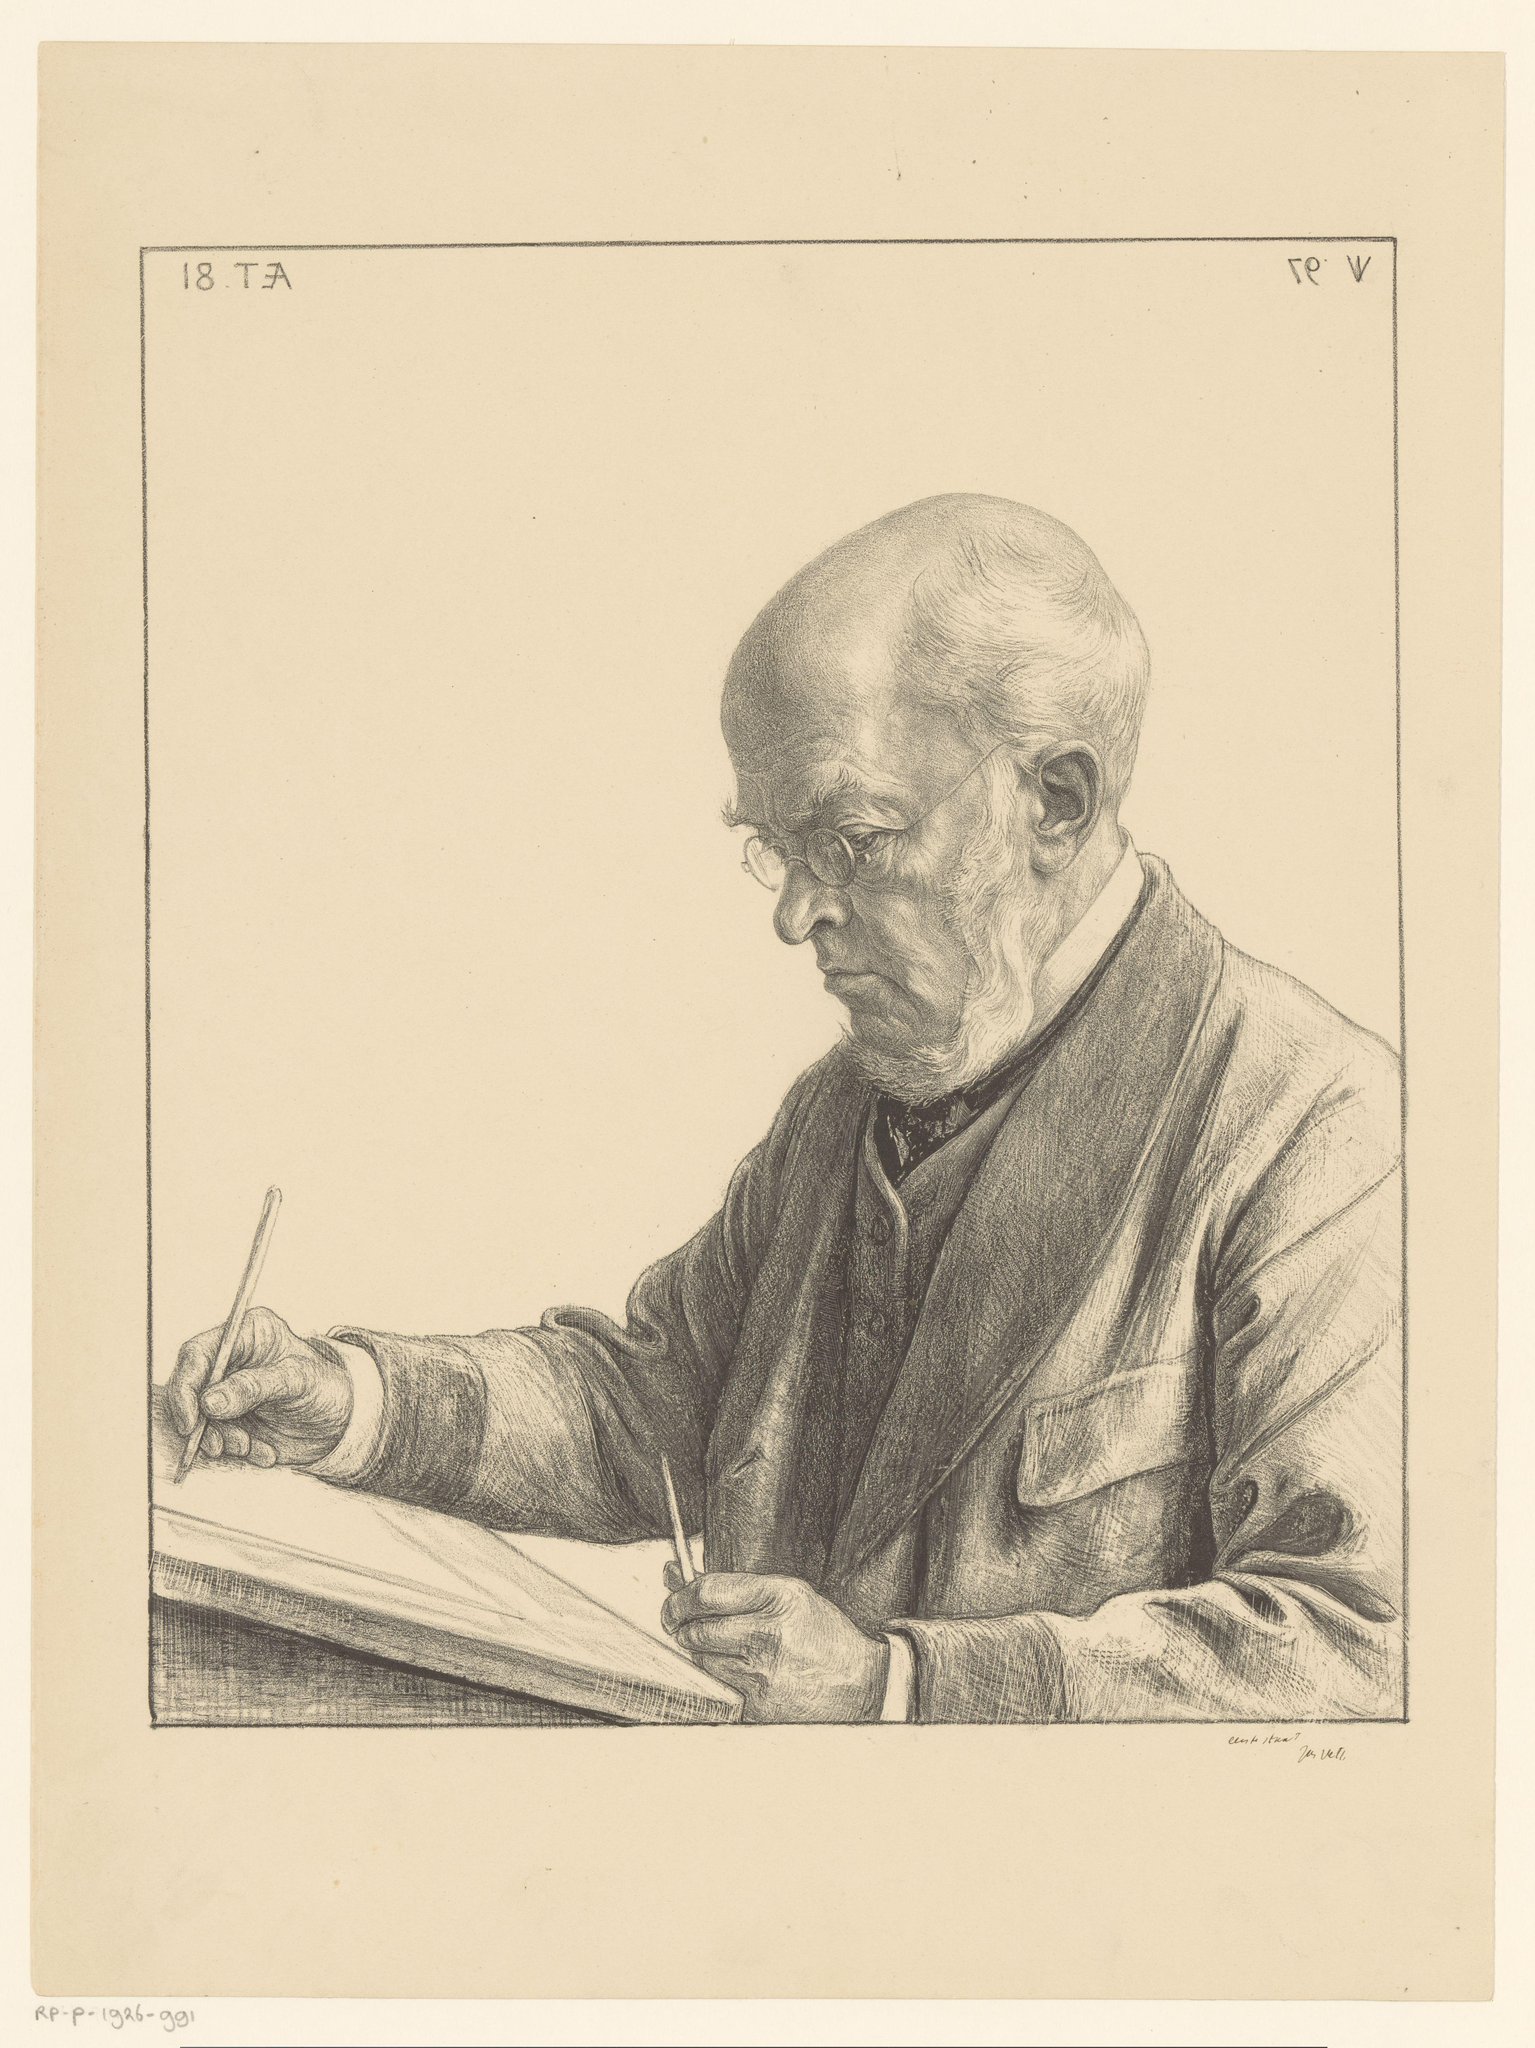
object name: print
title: Portret van Adolph Menzel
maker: jan veth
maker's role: designer, draughtsman, painter, print maker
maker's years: 1864-1925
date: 1897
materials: paper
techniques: lithograph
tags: berlin, painter, print maker, draughtsman, adolph menzel, draughtsman at work, historical persons (+ (full) bust portrait)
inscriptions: collector's mark: Lugt 2228, inscription: ‘eerste staat / Jan Veth’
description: De geportretteerde is bezig met een tekening.